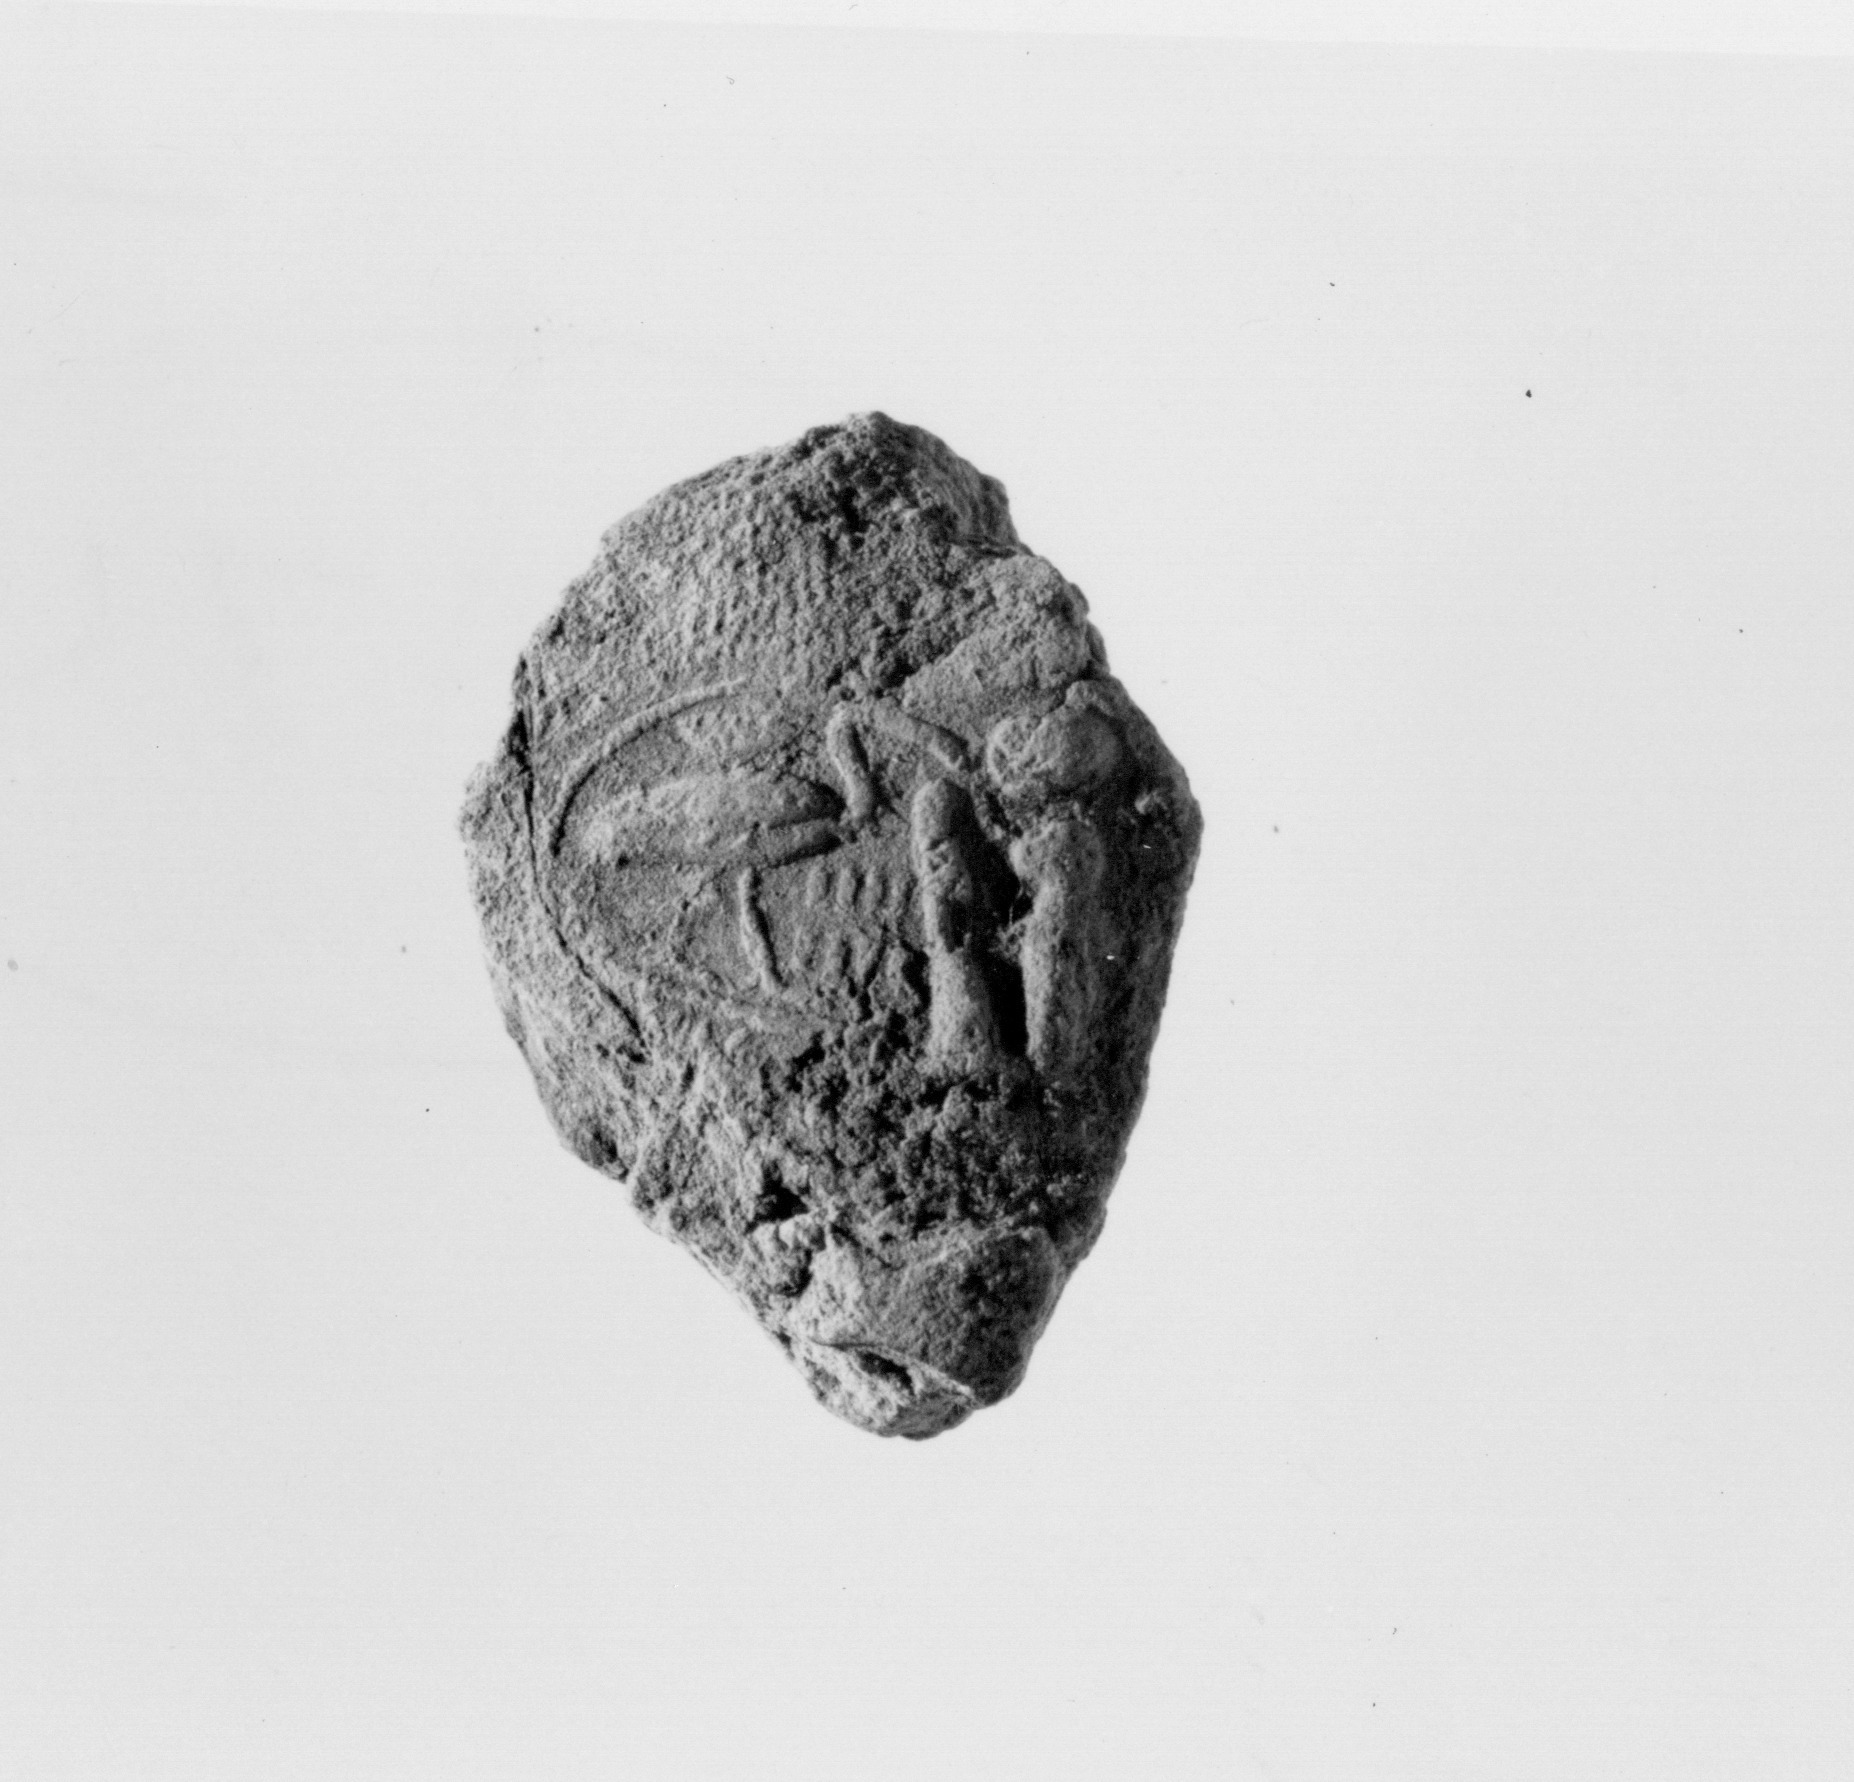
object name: sealing, nebmaatre, amenhotep iii, heb sed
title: Document Sealing With the Throne Name of Amenhotep III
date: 1390-1352 BCE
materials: mud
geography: egypt